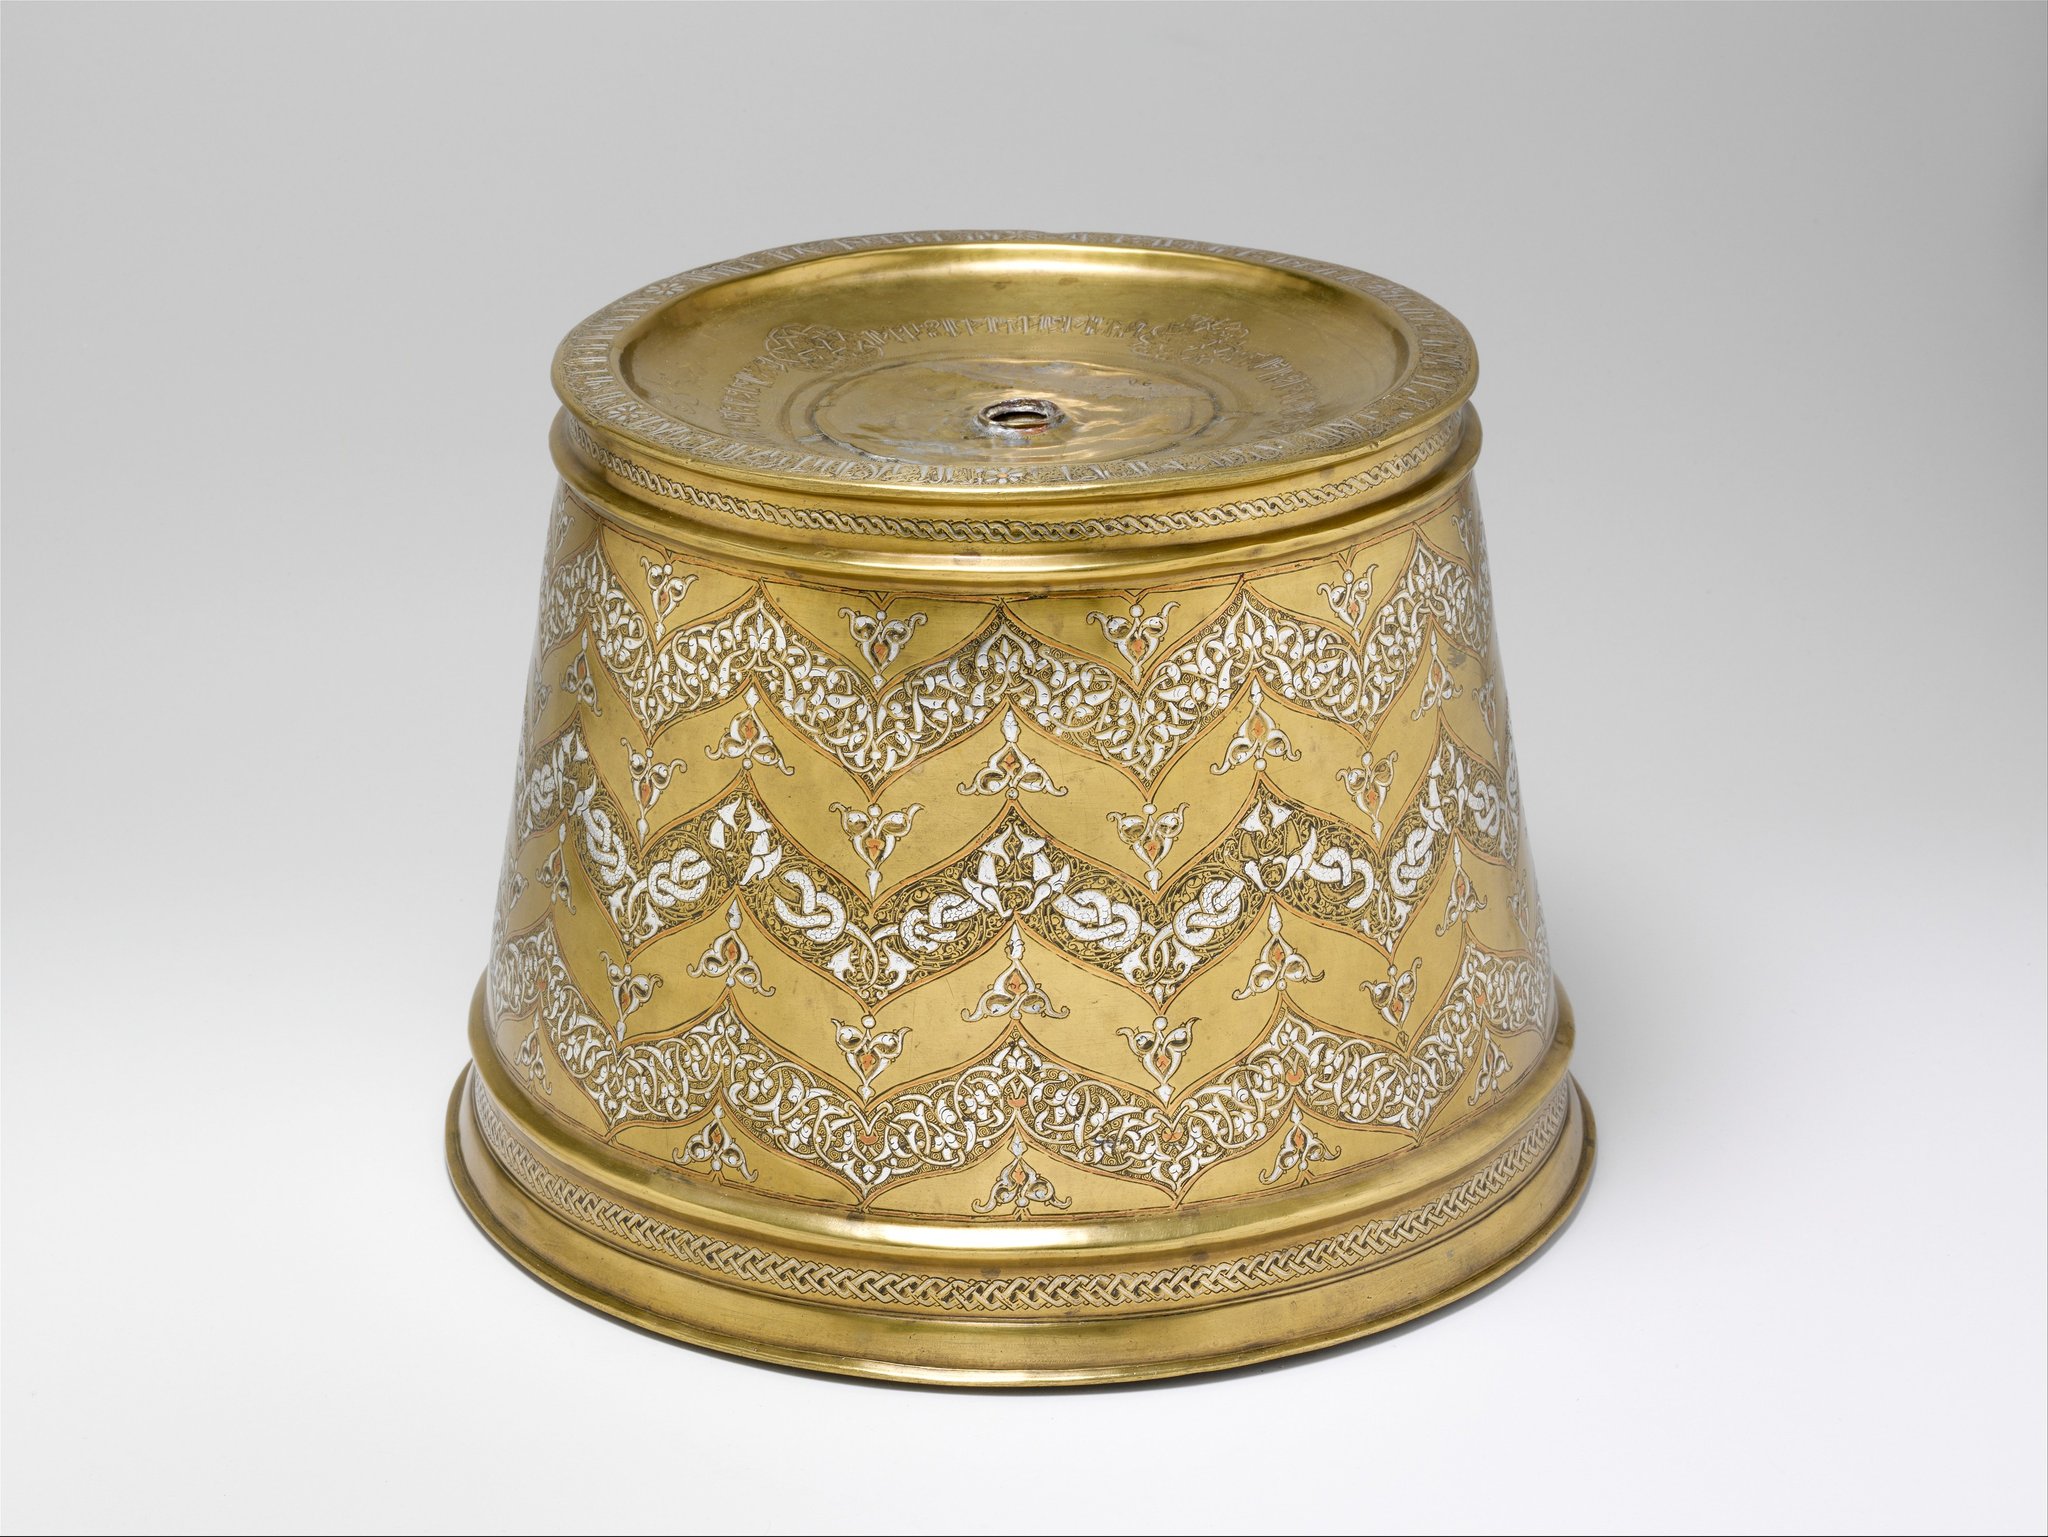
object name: candlestick base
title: Candlestick Base with Interlacing Dragons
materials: brass, copper, silver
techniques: inlay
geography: iraq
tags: dragons